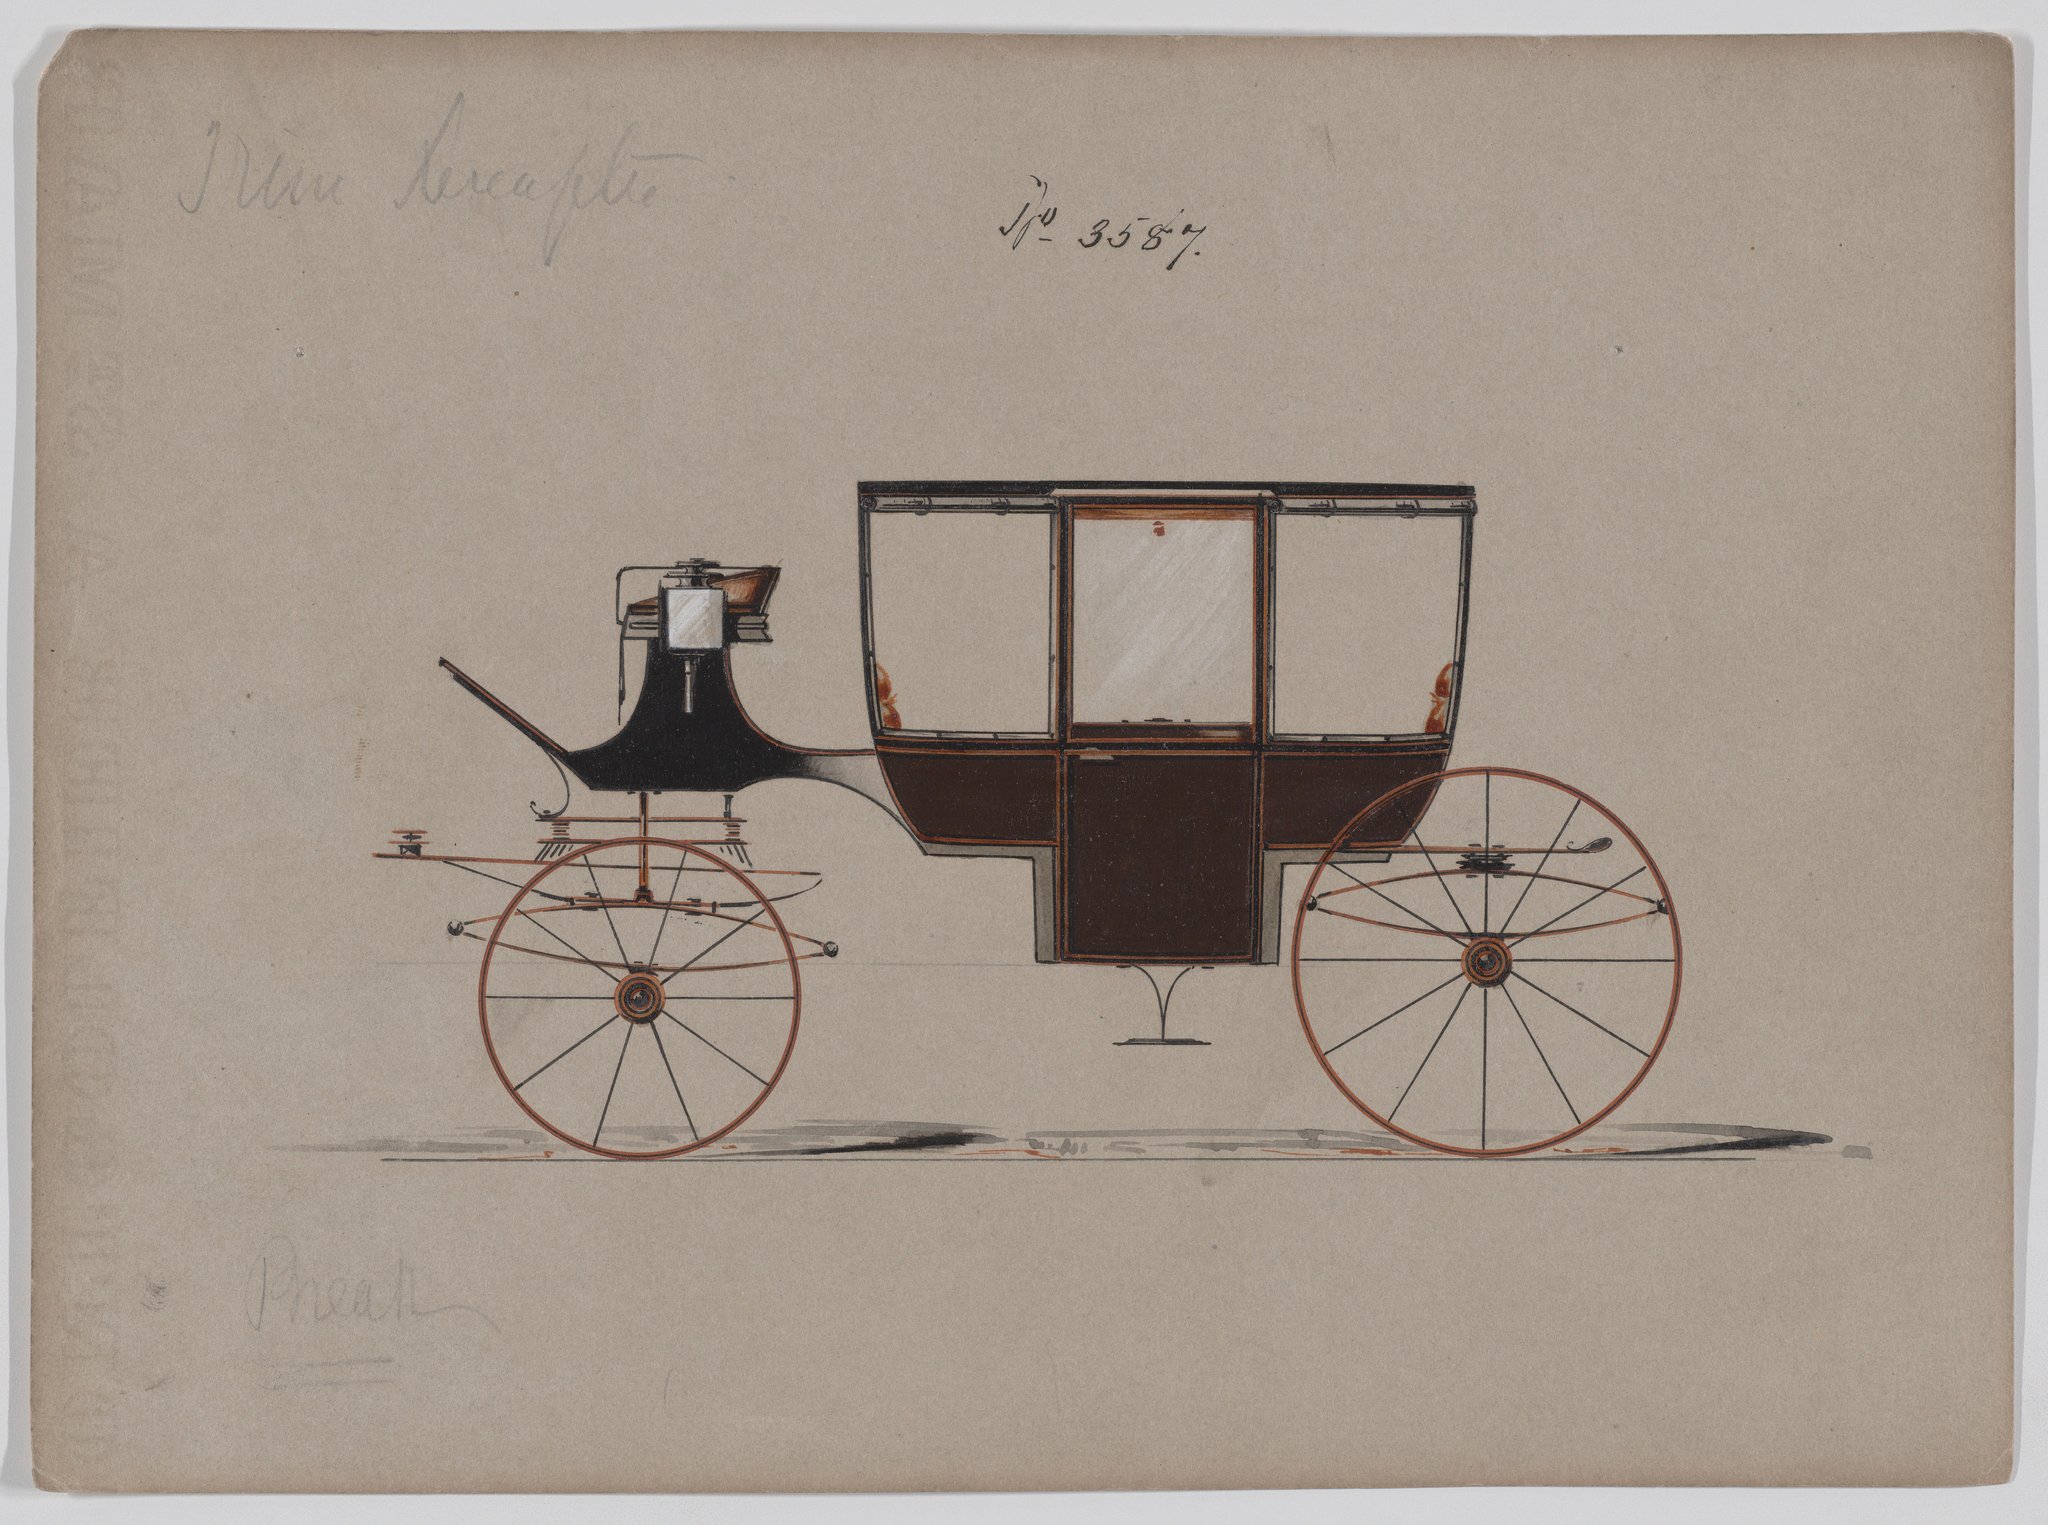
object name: drawing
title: Coach #3587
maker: brewster & co.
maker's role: manufacturer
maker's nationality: american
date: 1880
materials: gouache, gum arabic, ink, watercolor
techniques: pen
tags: carriages